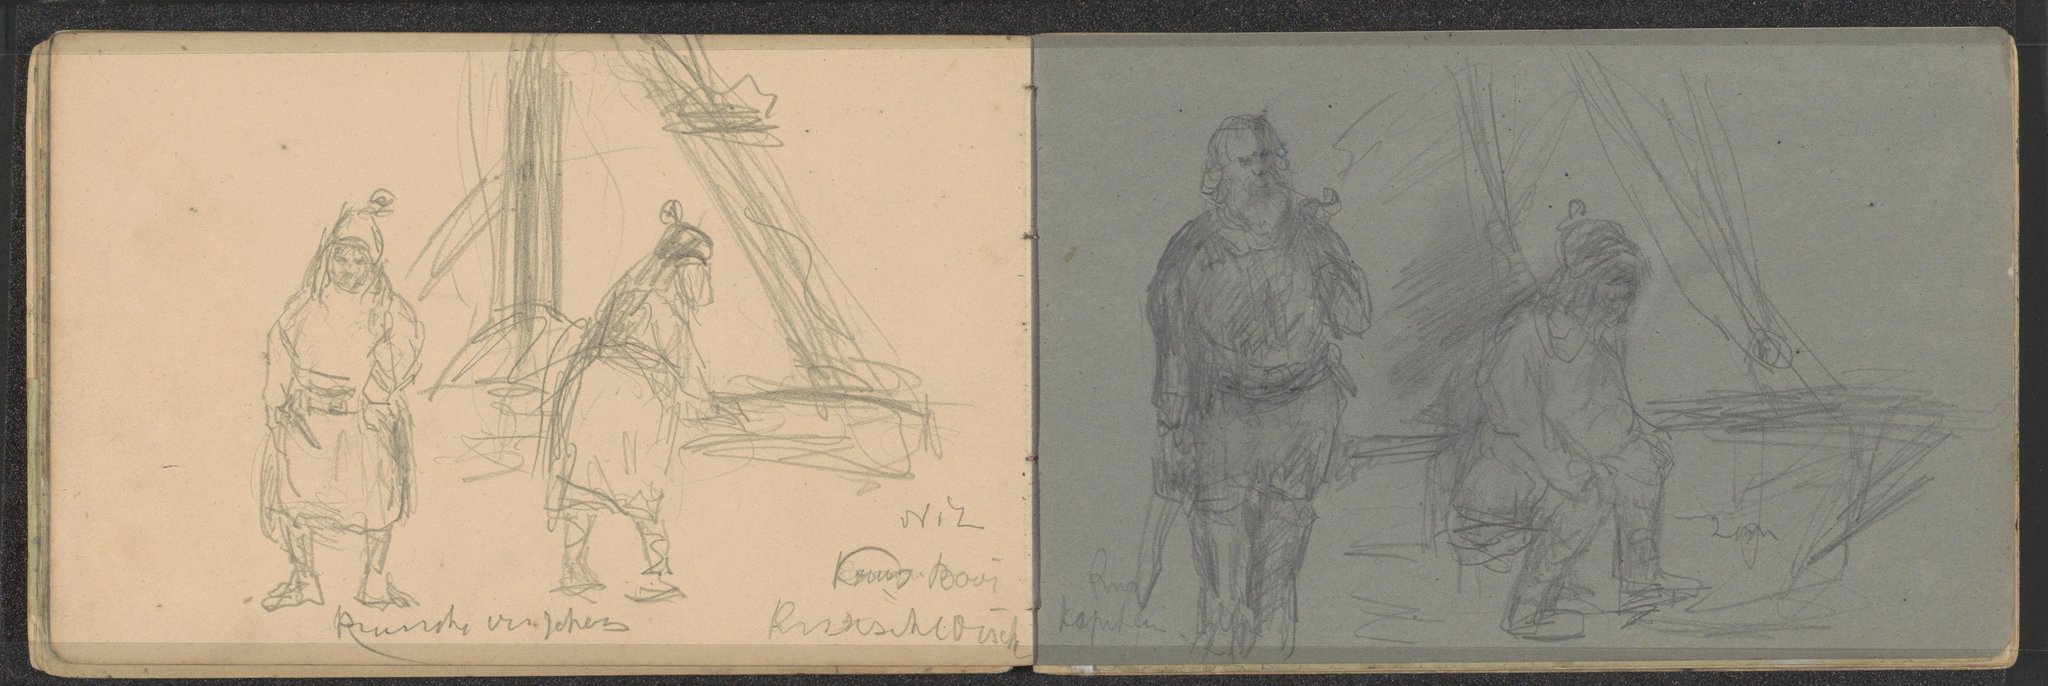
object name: sketchbook leaf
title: Russische vissers voor een kruisboot bij Nova Zembla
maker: louis apol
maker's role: draughtsman, painter, print maker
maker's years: 1850-1936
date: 1880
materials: paper, pencil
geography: novaya zemlya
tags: commercial fishery (+ labourers ~ crafts, industries, agriculture), ships (in general)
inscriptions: annotation: ‘Russche [sic] visschers/ N.Z/ Kruis Boot/ Russische visch’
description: Blad 22 verso uit een schetsboek met 35 bladen betekend tijdens de expeditie naar Nova Zembla in 1880.